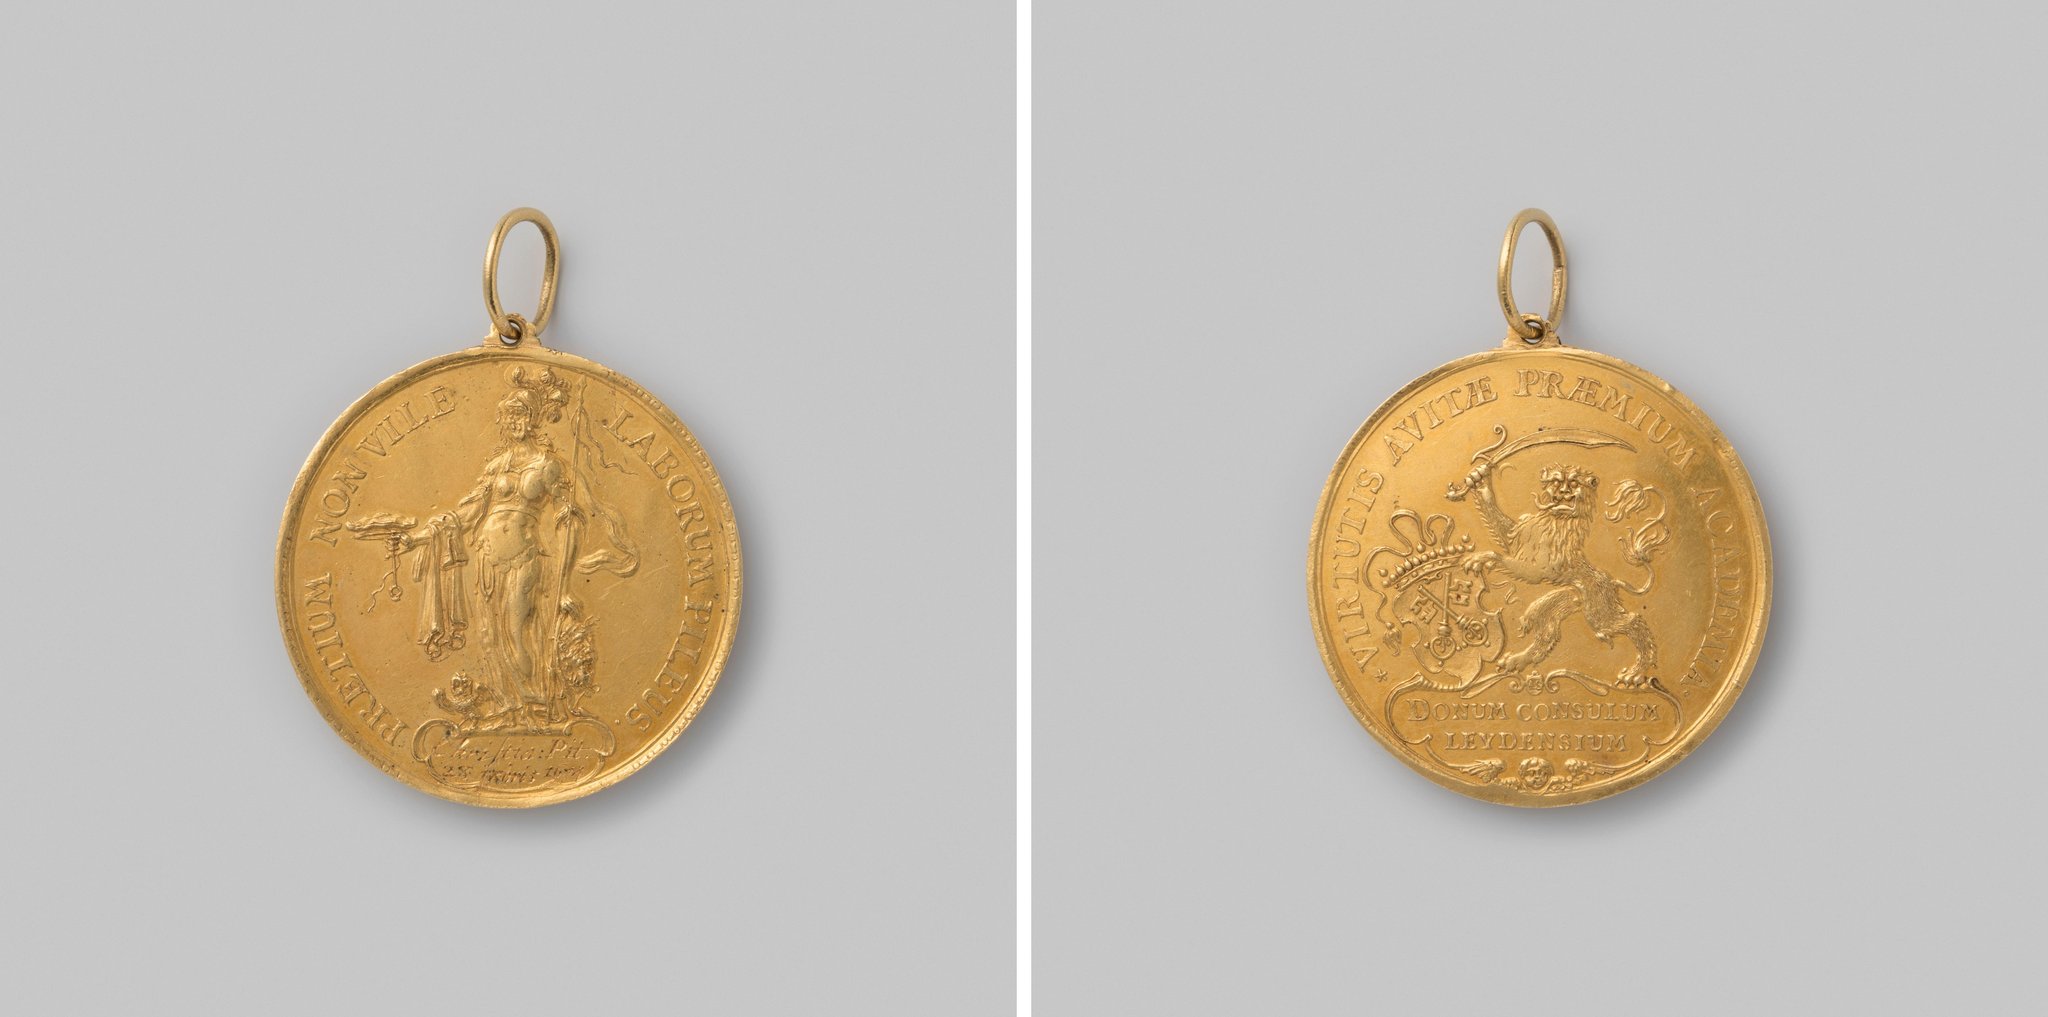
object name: honorary medal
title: Penning, verleend aan Christaan Pit door de Stad Leiden ter gelegenheid van de verdediging van zijn dissertatie aan de Universiteit van Leiden op 28 november 1674 (zogenaamde promotie met de kap)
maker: arent schmeltzing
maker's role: medailleur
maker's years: -1710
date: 1671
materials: gold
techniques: striking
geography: leiden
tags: leiden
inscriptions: circumscription: ‘VIRTUTIS AVITAE PRAEMIUM ACADEMIA.’, inscription: ‘Christia: Pit. 28 ixbris 1674’, circumscription: ‘PRETIUM NON VILE LABORUM PIILEUS.’, inscription: ‘DONUM CONSULUM LEYDENSIUM’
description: 1674 Is de datum van uitreiking van de penning; het ontwerp dateert van 1671.